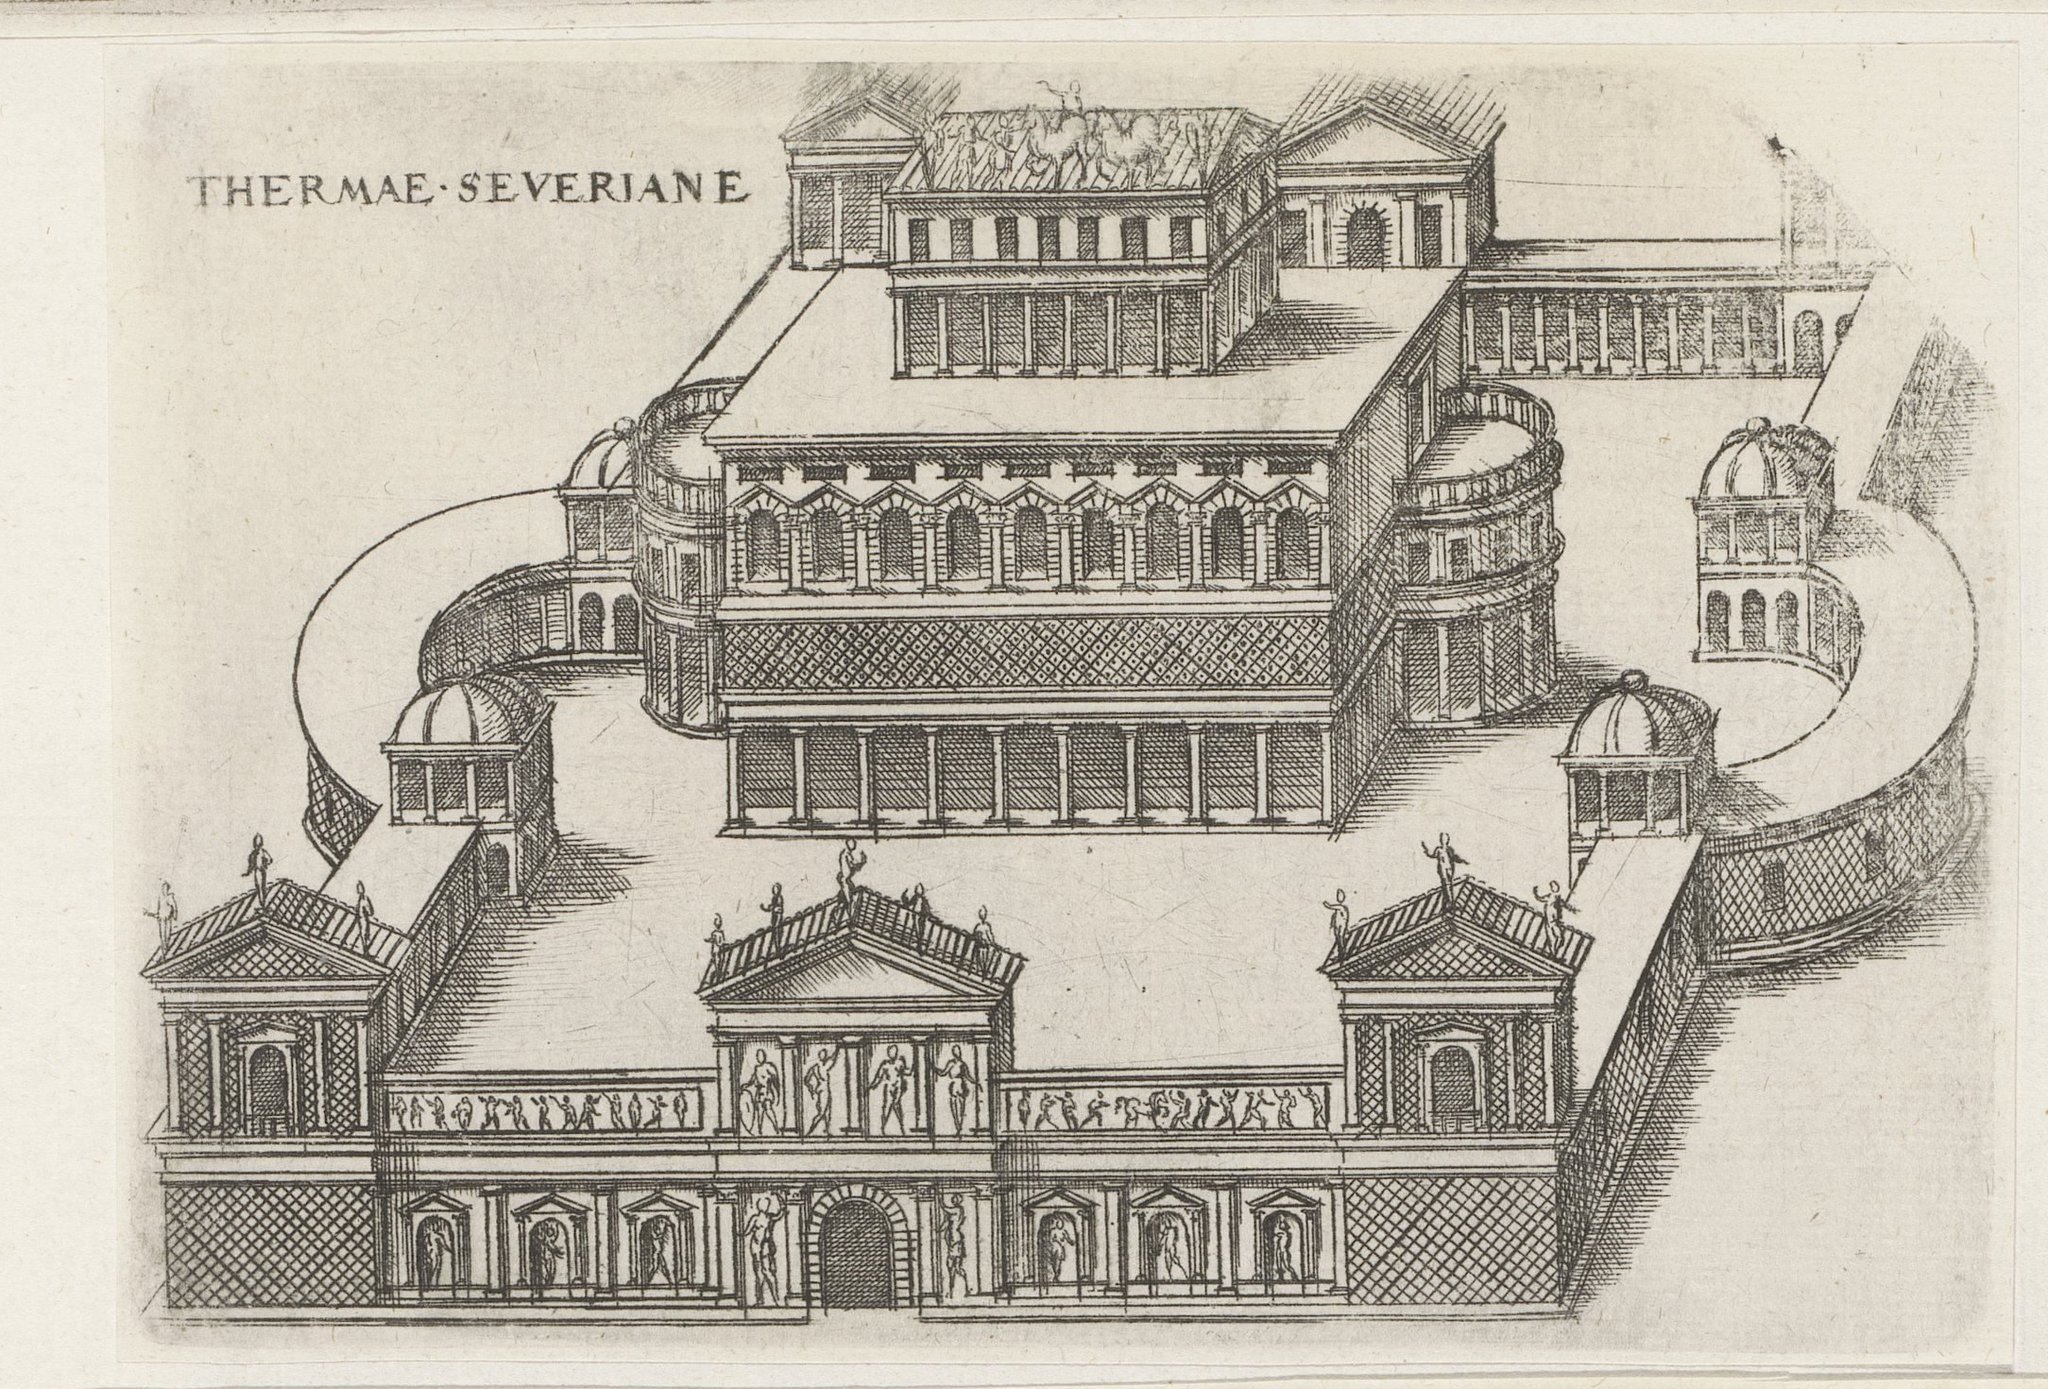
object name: album leaf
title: Magesyn der Italiaense gebouwen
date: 1584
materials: paper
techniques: etching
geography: france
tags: public baths, representation of real building (either existing or having existed)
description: Deze prent maakt deel uit van een serie van 98 prenten gedrukt op 48 bladen. De bladen zijn verknipt en een selectie van de losse prenten is in dit album geplakt.